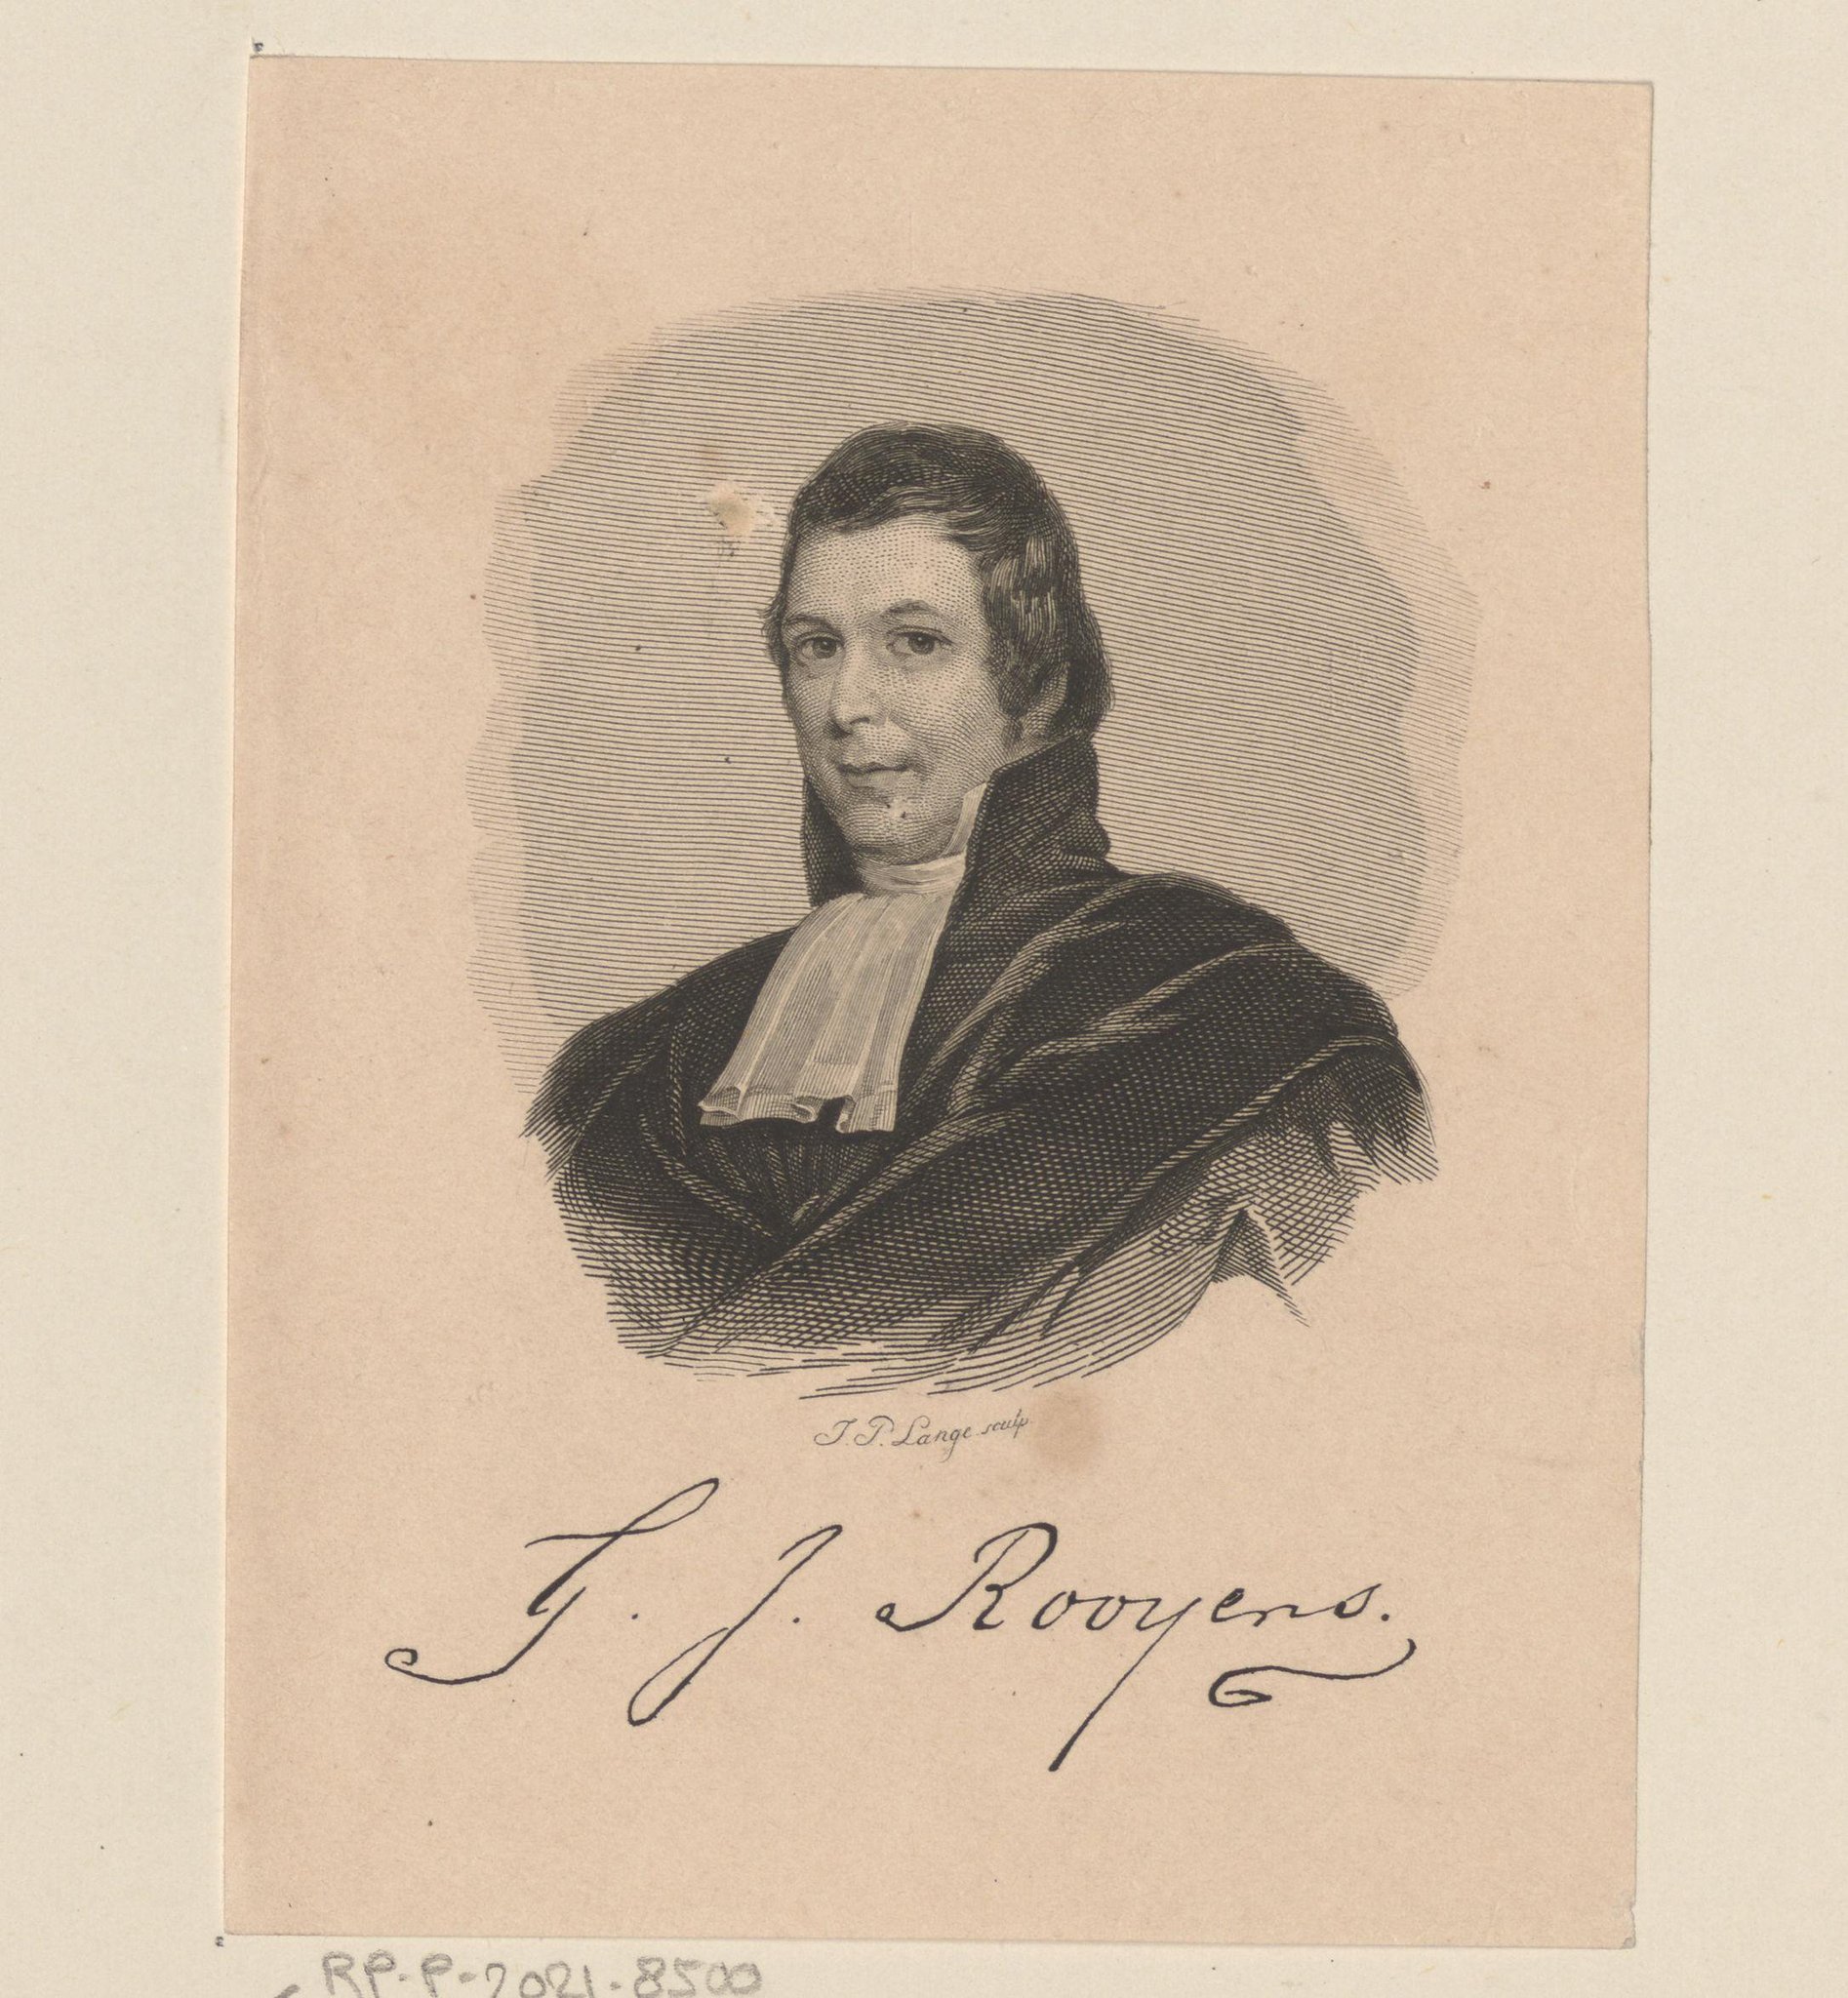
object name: print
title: Portret van Gijsbertus Johannes Rooyens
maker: johannes philippus lange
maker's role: print maker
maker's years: 1810-1849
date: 1820-1849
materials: paper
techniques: engraving, etching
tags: den bosch, amsterdam, historical persons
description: Onder het portret een facsimile van de handtekening van de geportretteerde.